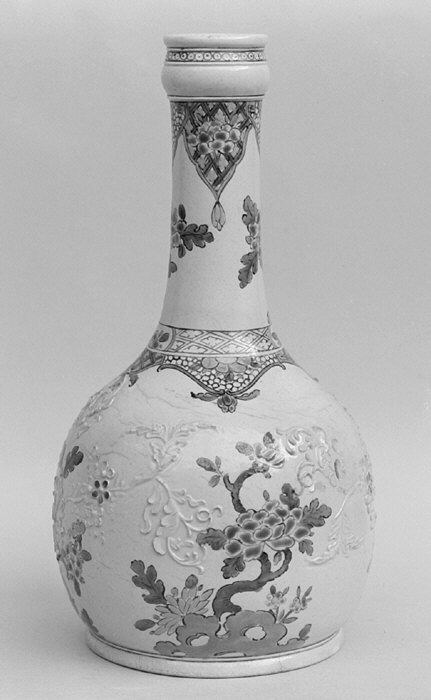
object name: bottle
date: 1760-1765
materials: stoneware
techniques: salt glaze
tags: flowers